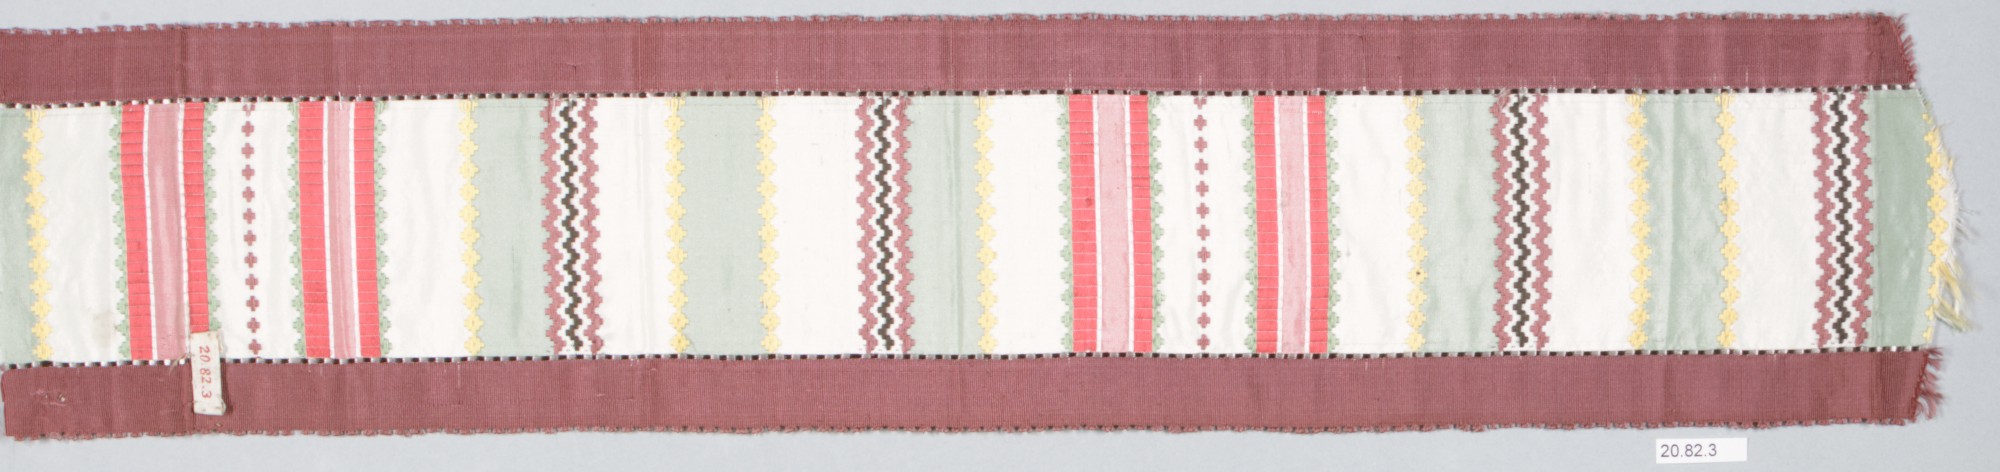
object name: ribbon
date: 1801-1833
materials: silk